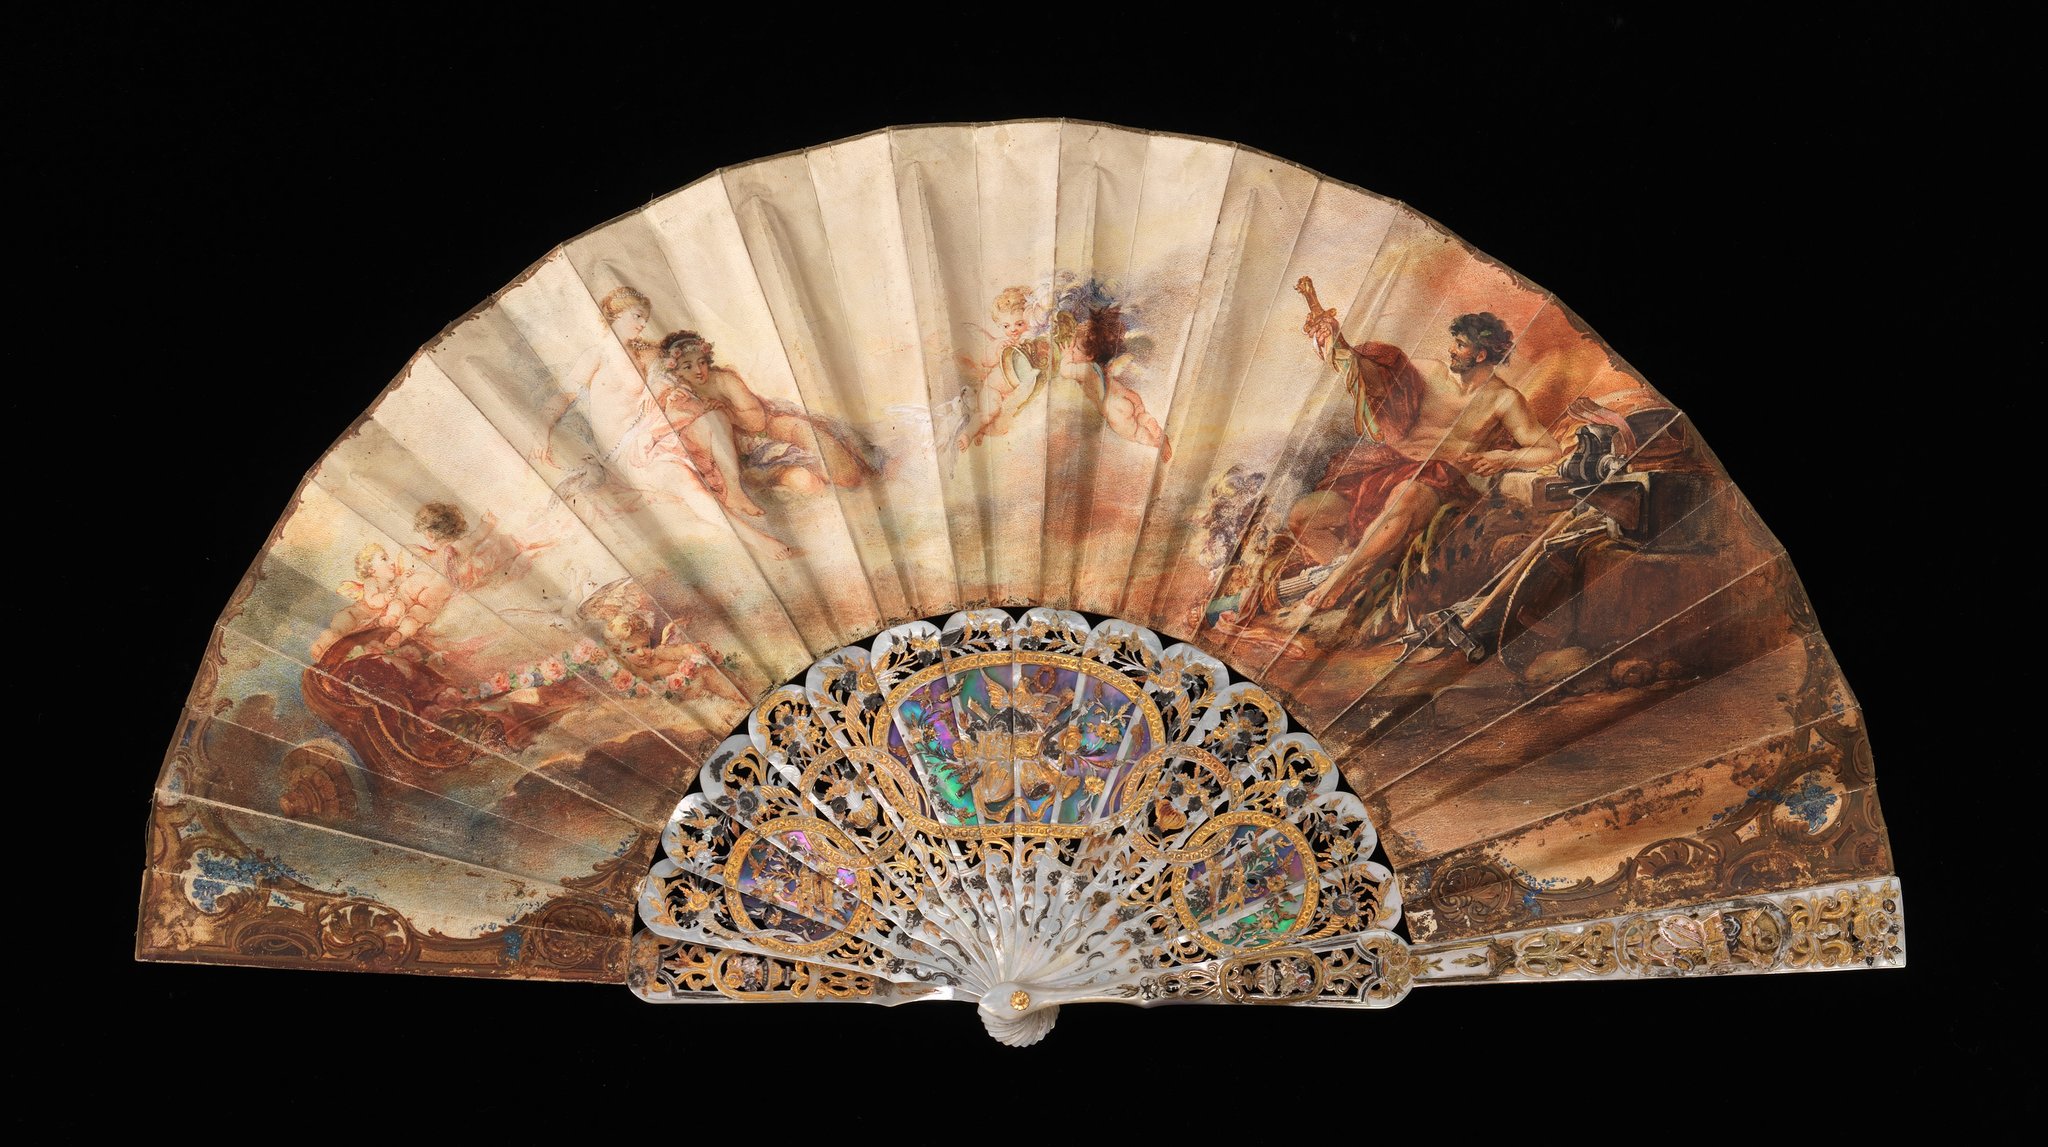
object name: fan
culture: italian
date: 1876-1900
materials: gouache, metal, mother of pearl, parchment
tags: men,women,putti